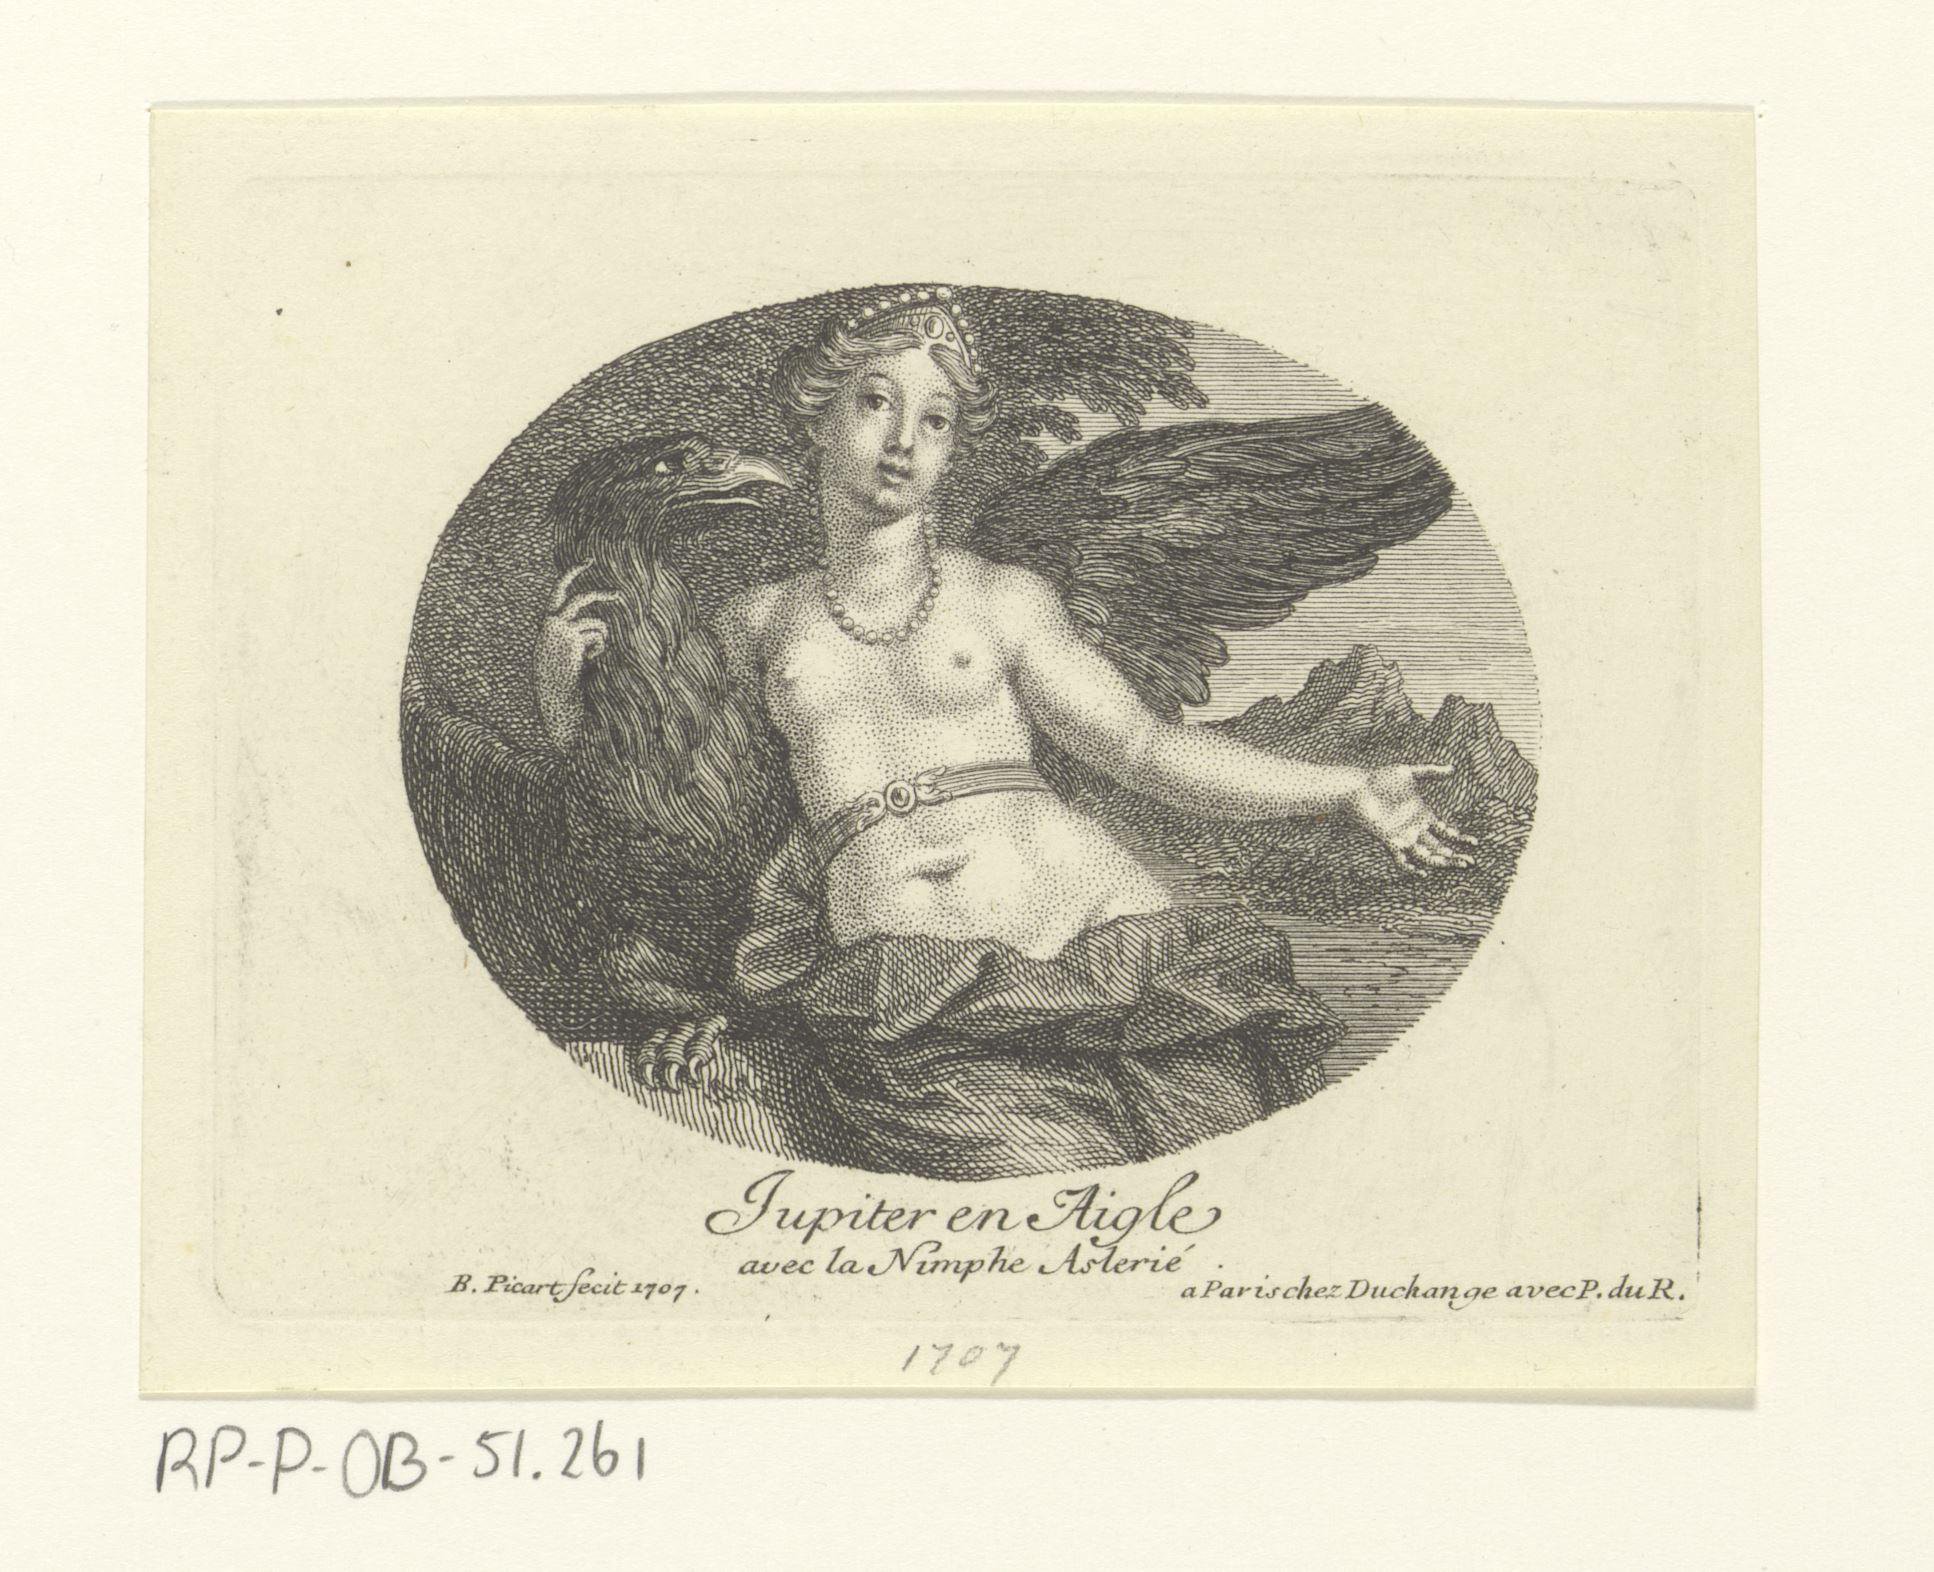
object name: print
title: Jupiter en Aigle avec la Nimphe Asterié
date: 1707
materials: paper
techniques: engraving, etching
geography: paris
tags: jupiter, in the form of an eagle, wrestles with asteria (as yet not metamorphosed)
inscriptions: collector's mark: Lugt 240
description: Prent is mogelijk opgenomen in een editie van: Fénelon, François de Pons de Salignac de la Mothe. Les aventures de Télémaque.